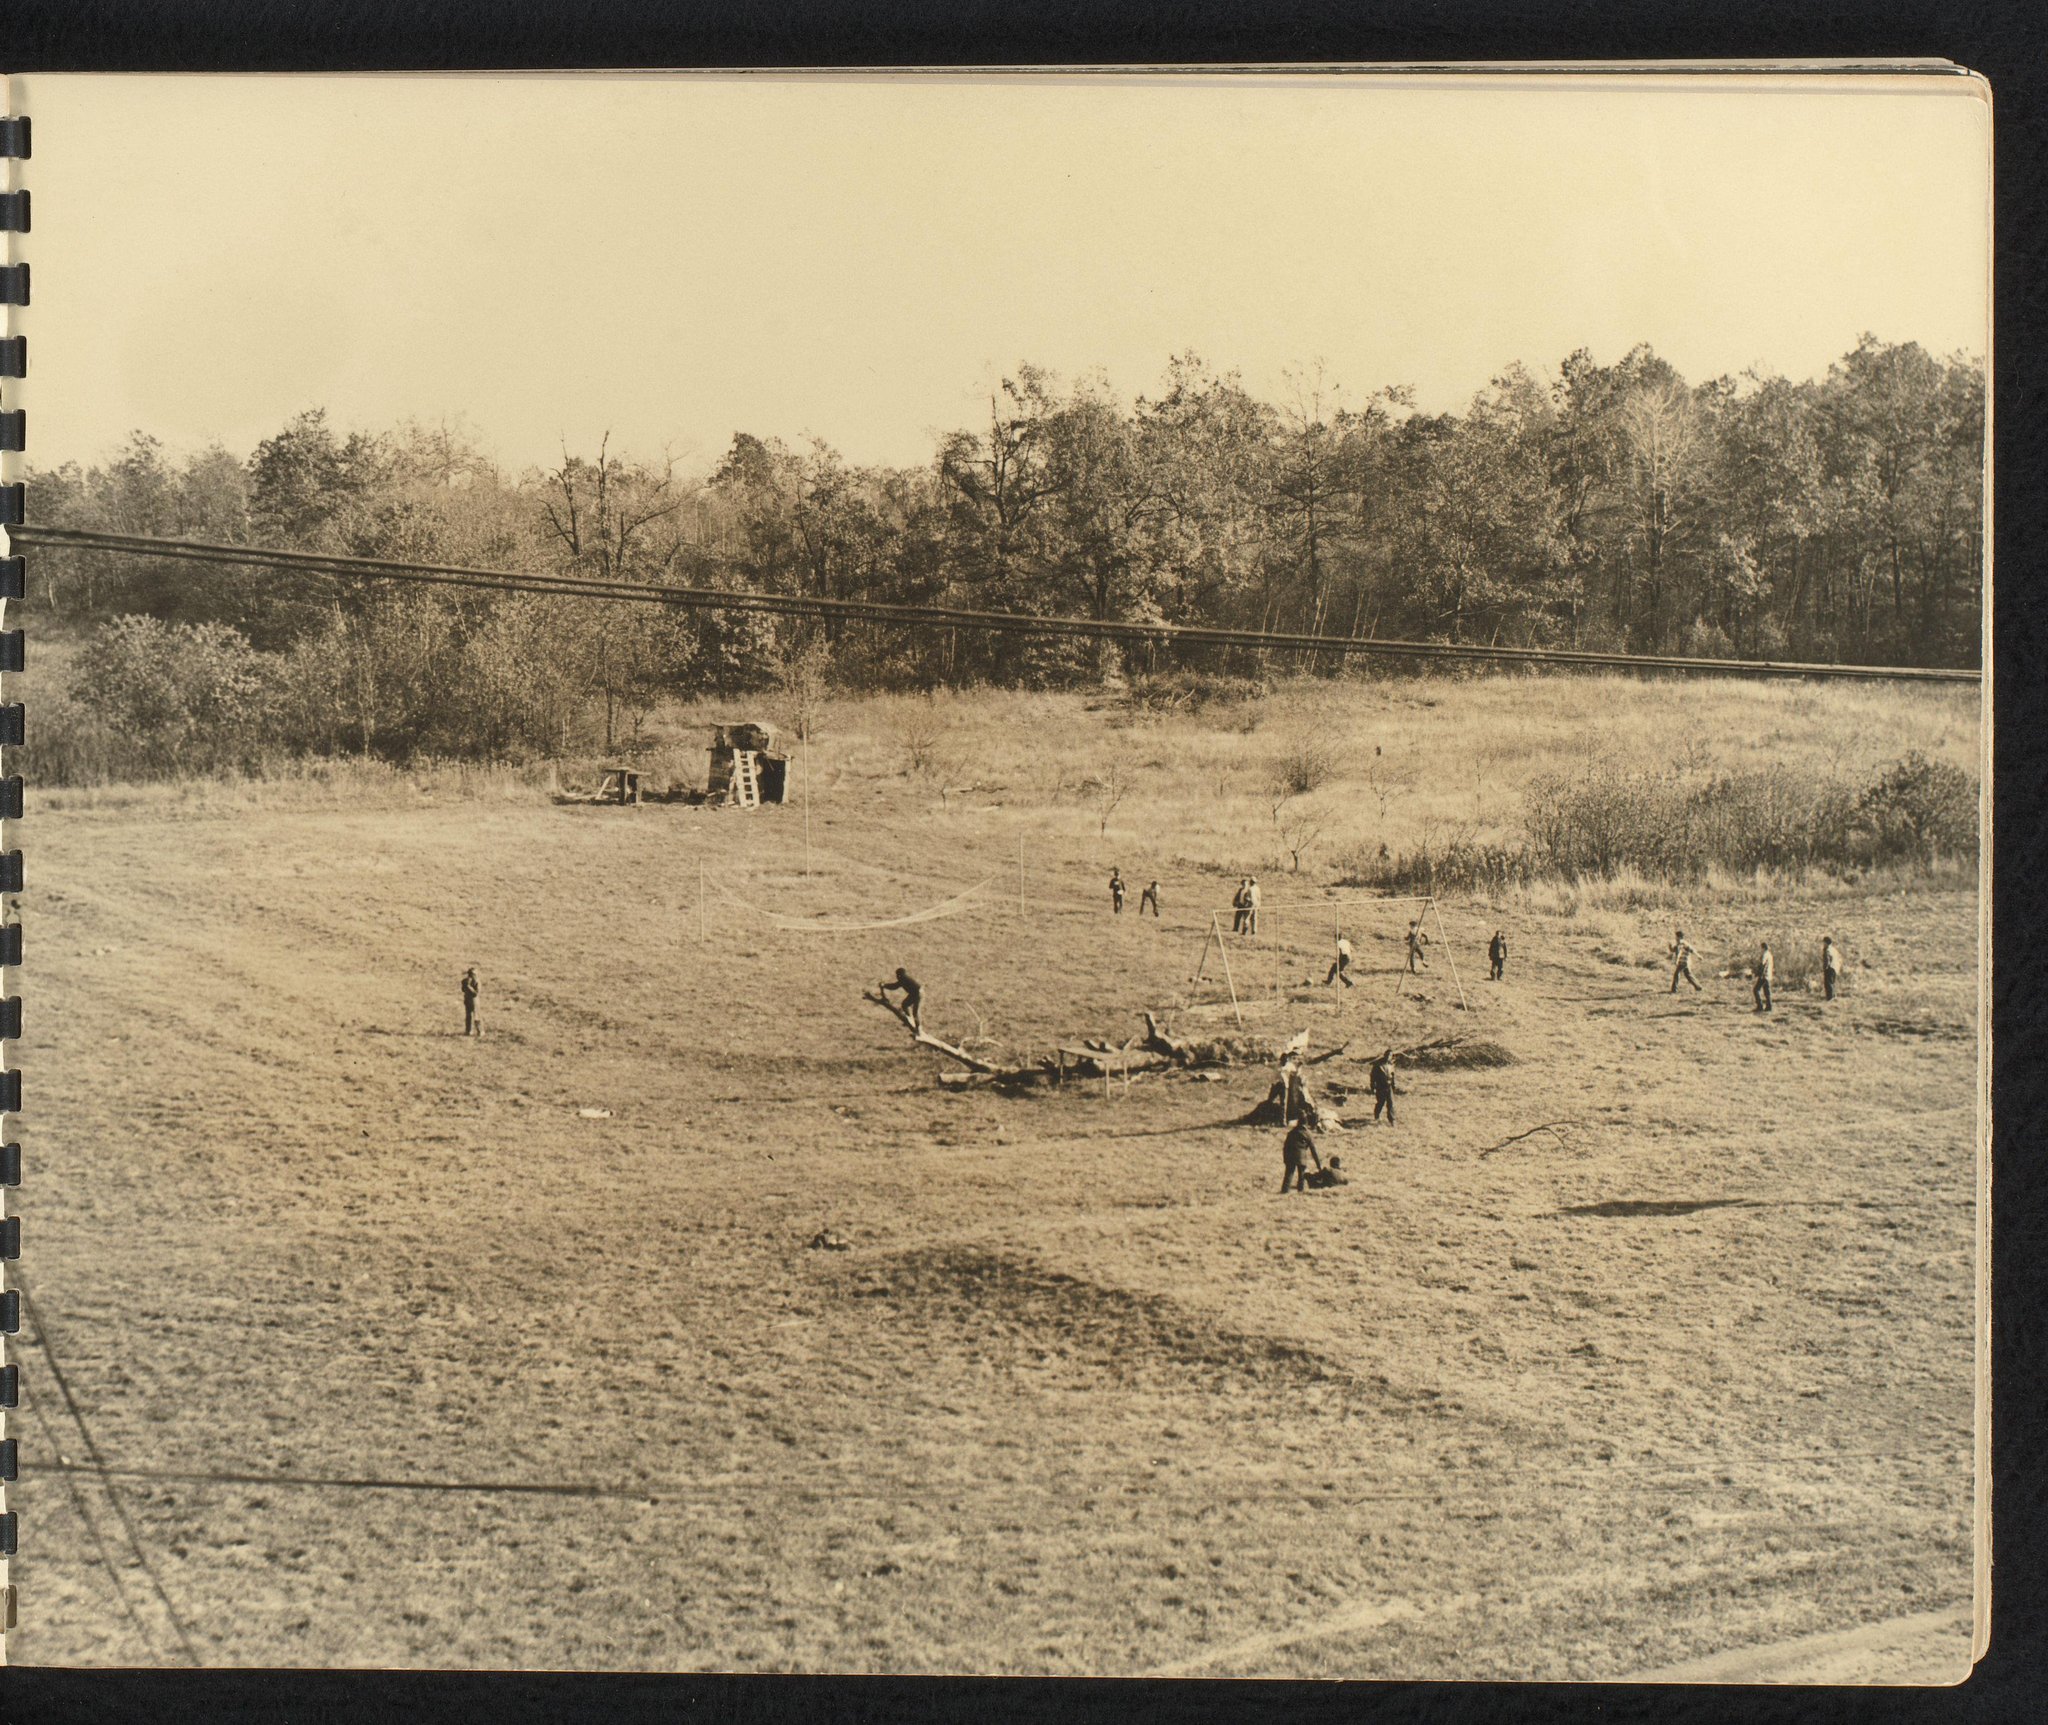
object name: photograph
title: Speelveld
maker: Anonymous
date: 1950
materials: paper, photographic support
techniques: gelatin silver print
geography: new york city